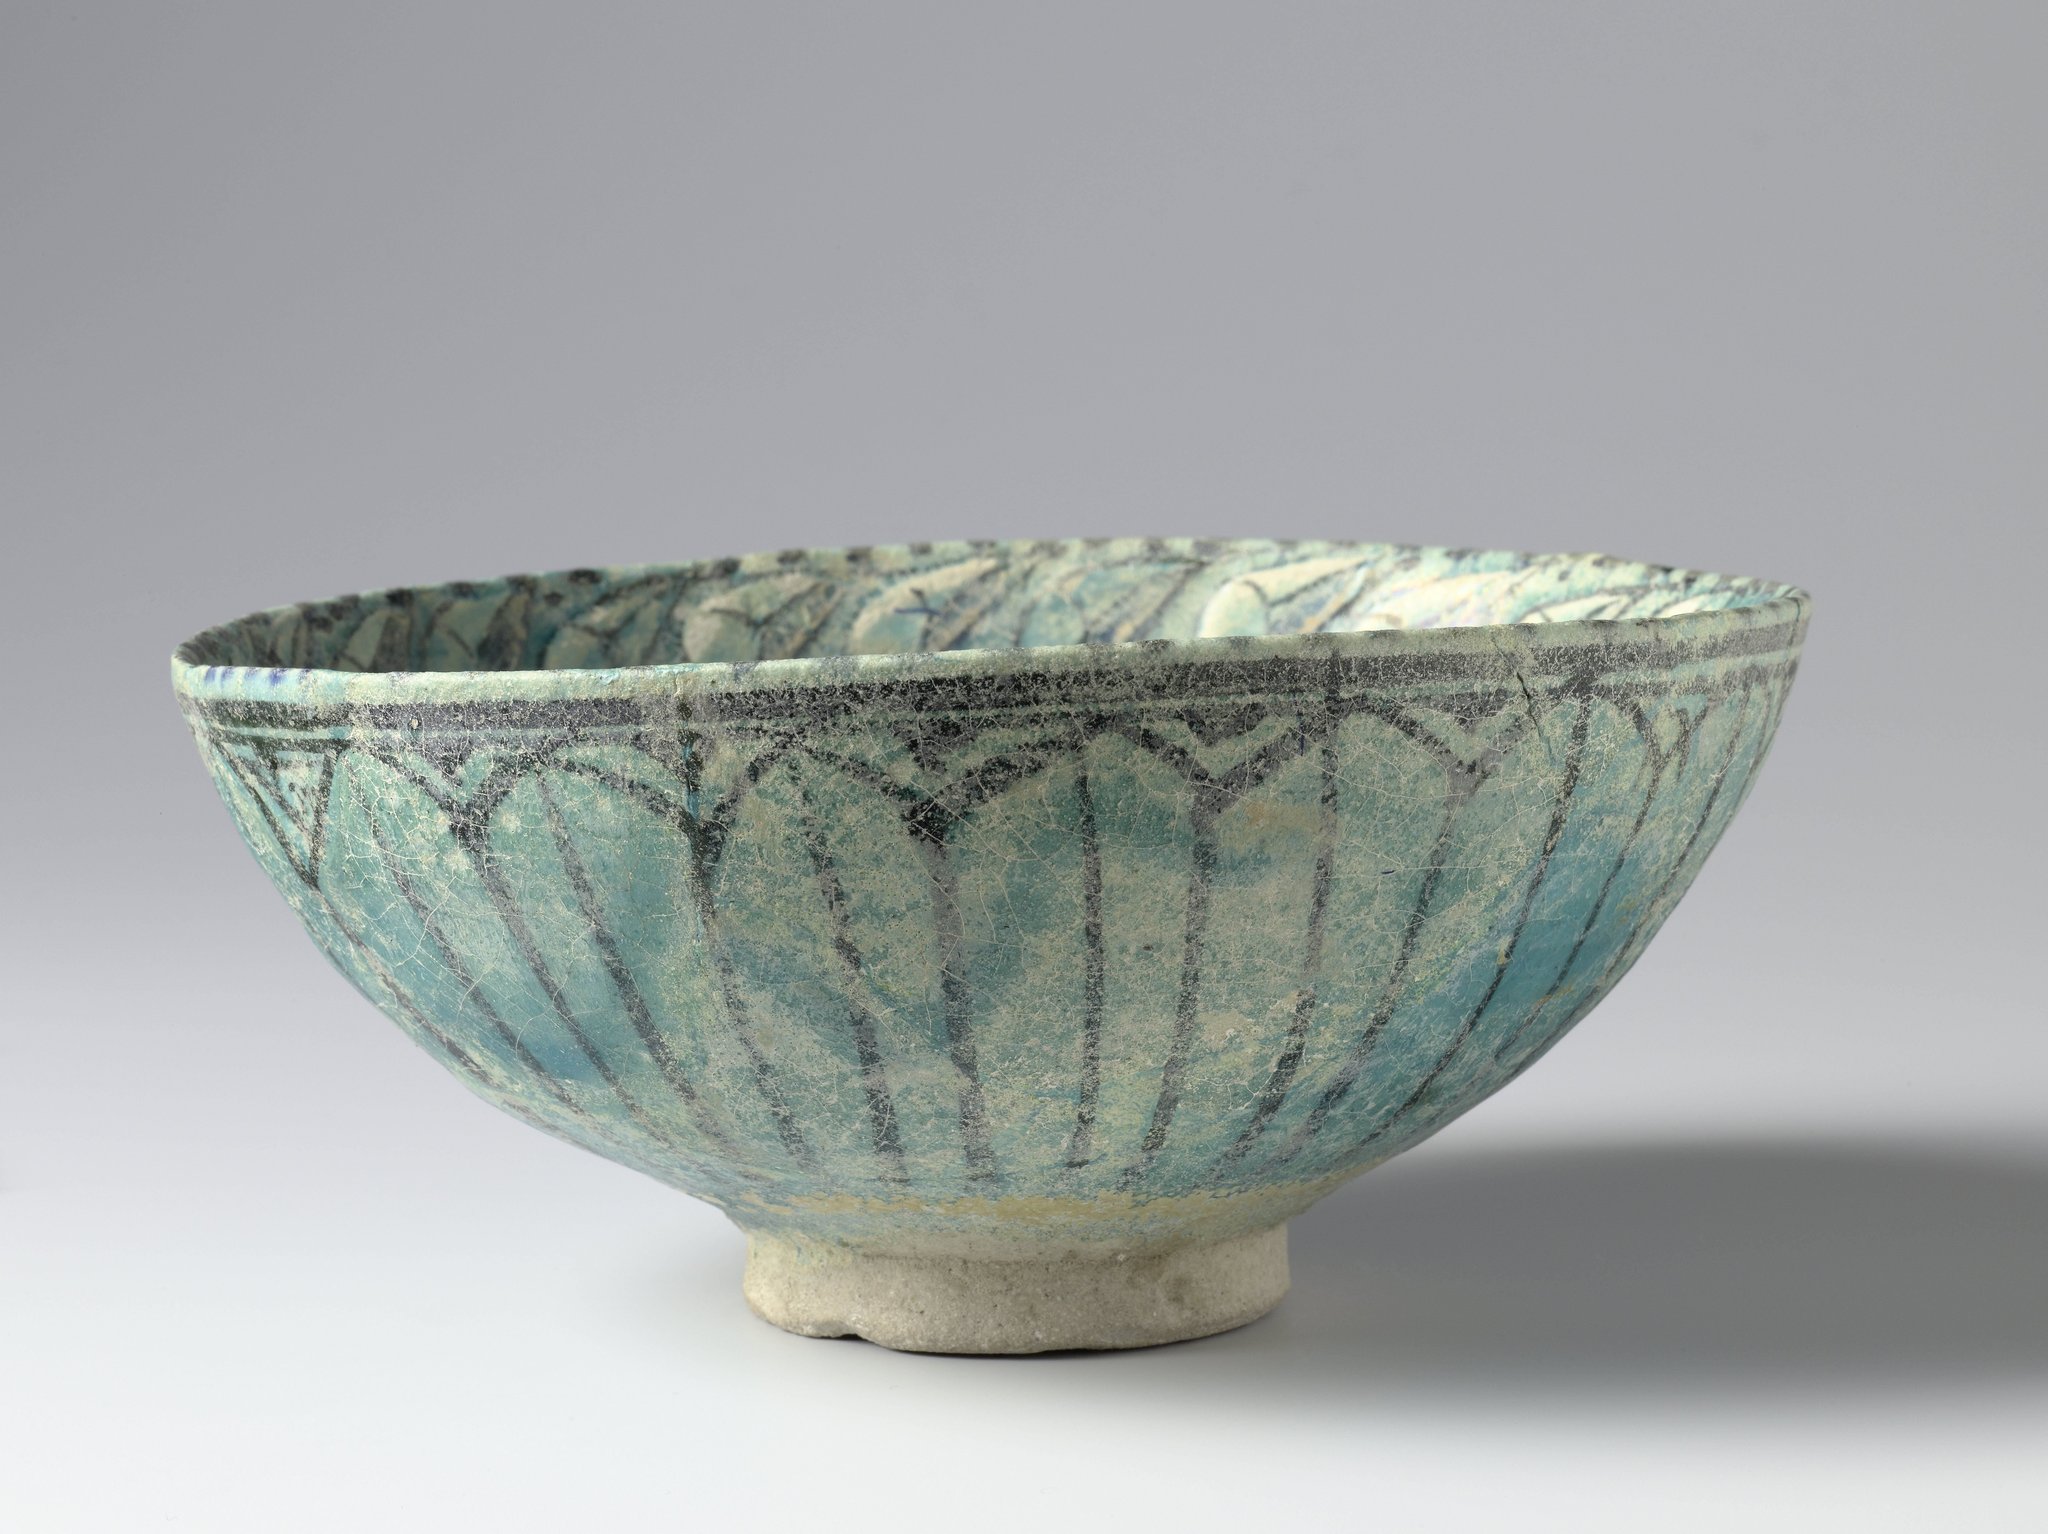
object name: bowl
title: Bowl with foliate scroll borders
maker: Anonymous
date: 1275-1324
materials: earthenware, glaze, paint, quartz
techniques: firing, turning, vitrification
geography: kashan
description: Kom van kwarts-fritgoed met een zwarte beschildering onder een transparant turquoise alkaliglazuur. Op de binnenwand banden met gemodelleerde bladranken. De buitenwand met bladmotieven.